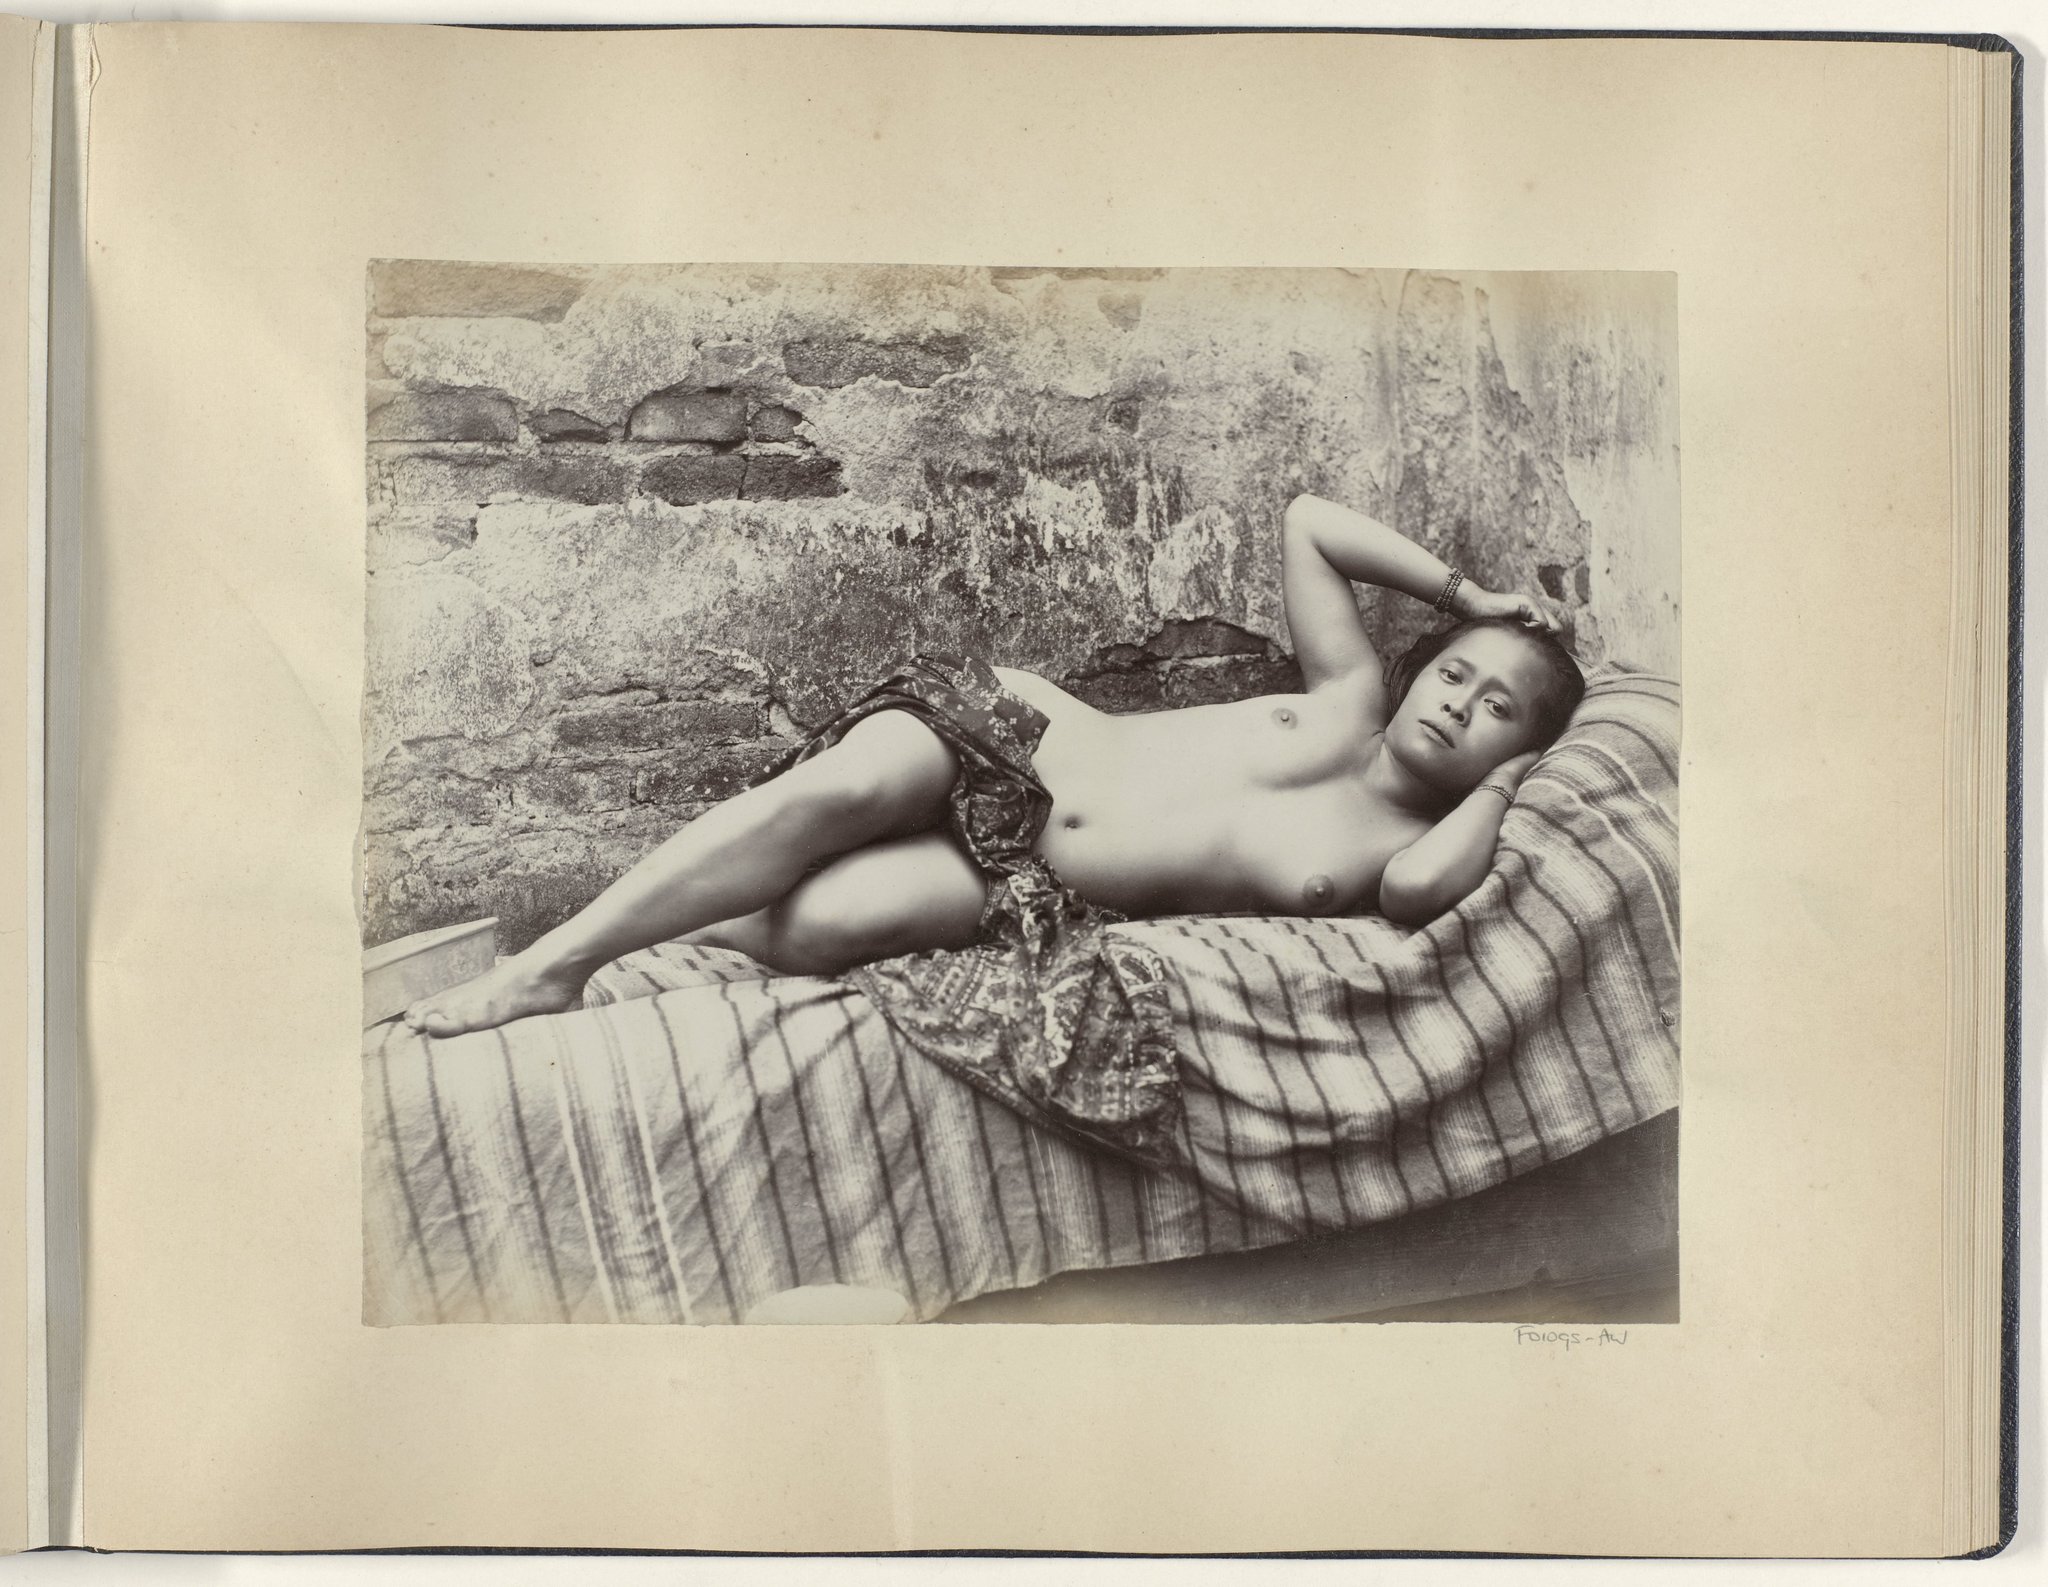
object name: photograph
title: Portret van een jonge halfnaakte Indische vrouw liggend op een divan, mogelijk op Sumatra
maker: Anonymous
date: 1895-1905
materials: paper, photographic support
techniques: albumen print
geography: sumatra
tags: studio requisites ~ photographer, woman (showing herself) undressed, quasi-nude, sumatra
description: Onderdeel van Reisalbum met foto's van bezienswaardigheden in Italië, Zwitserland en Nederlands-Indië.